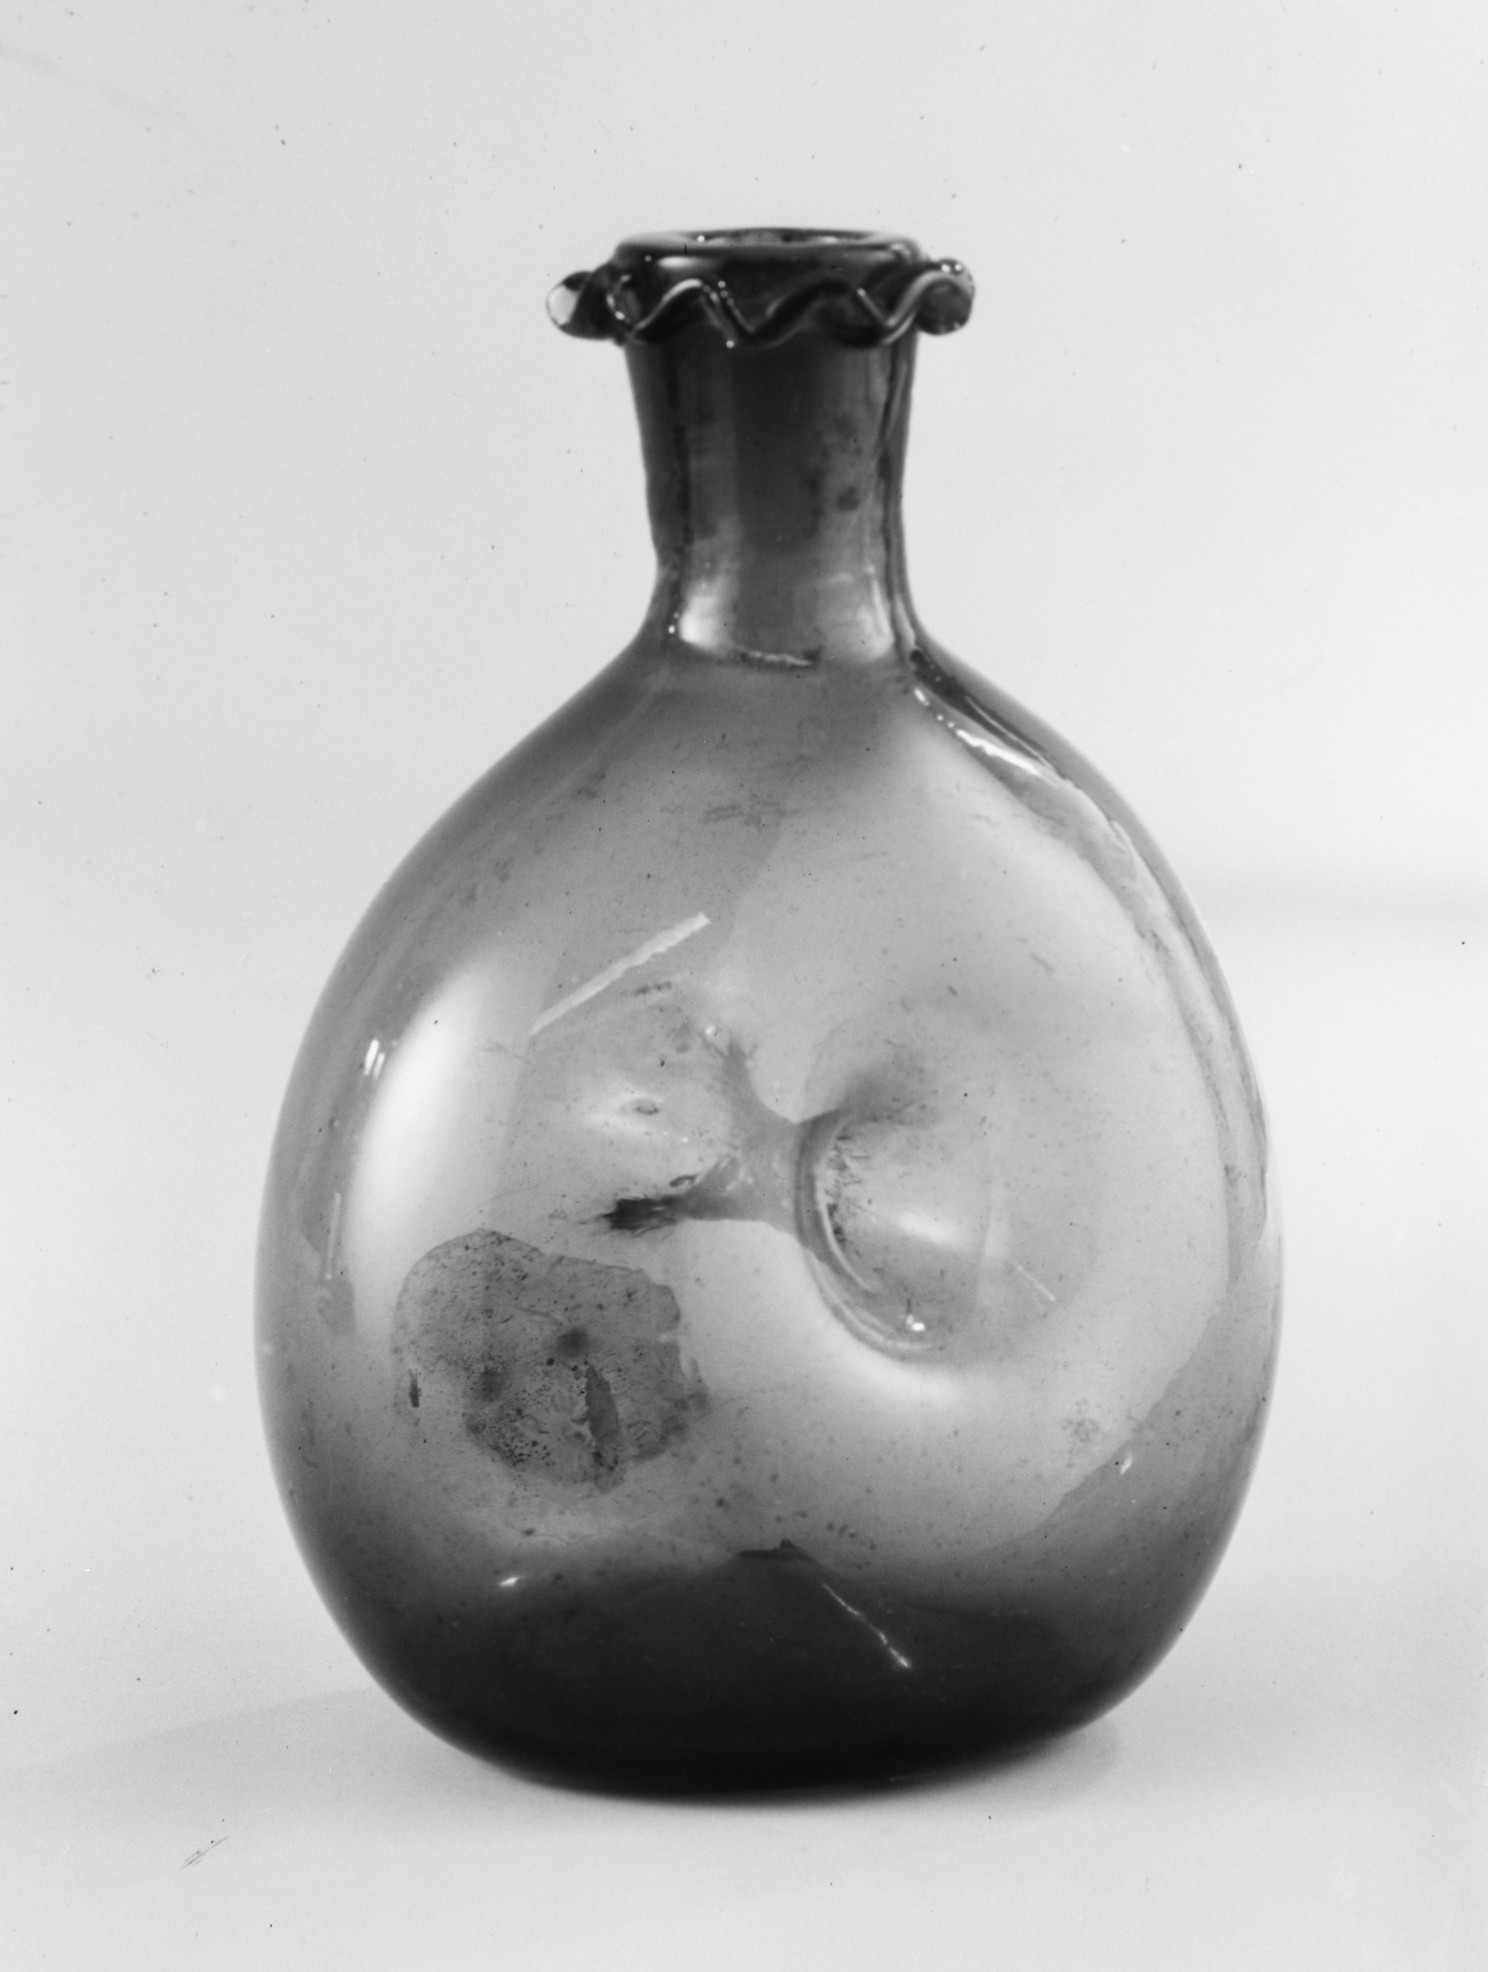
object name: pilgrim bottle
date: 1701-1800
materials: glass